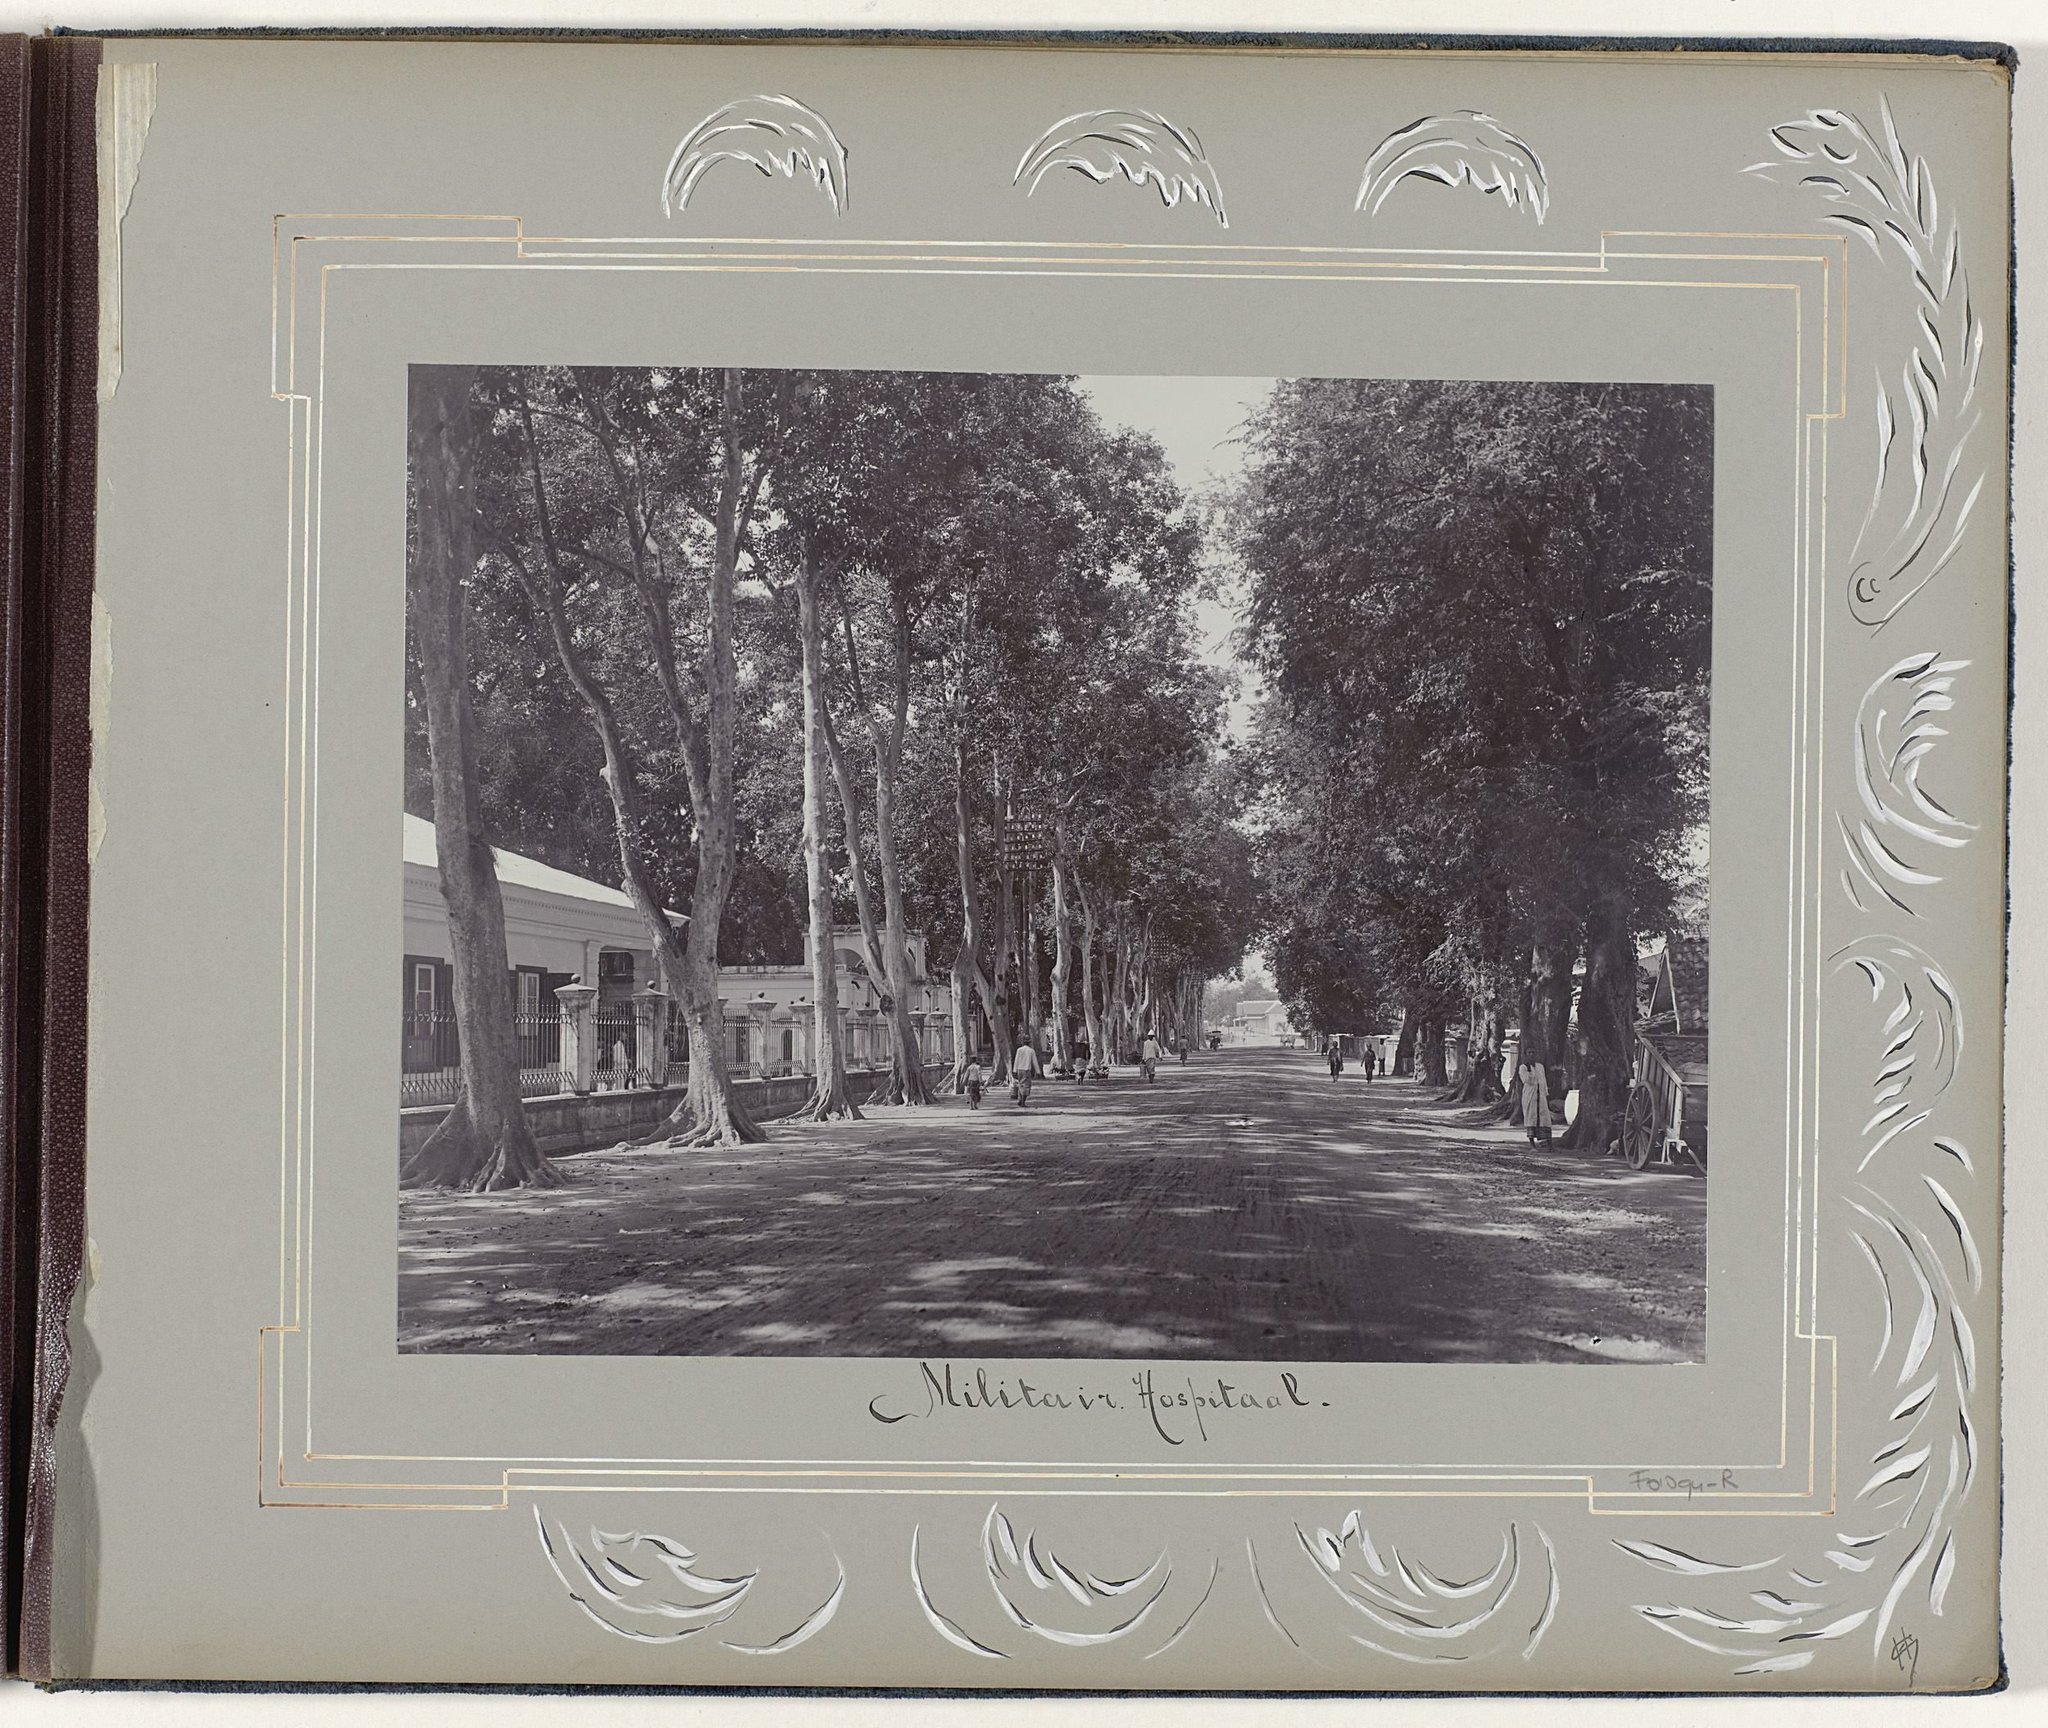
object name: photograph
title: Laan in Soerabaja met links het Militair Hospitaal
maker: Anonymous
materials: cardboard, paper, photographic support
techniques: gelatin silver print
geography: surabaya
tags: hospital, forest path or lane, surabaya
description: Onderdeel van Herinneringsalbum met foto's van Soerabaja.